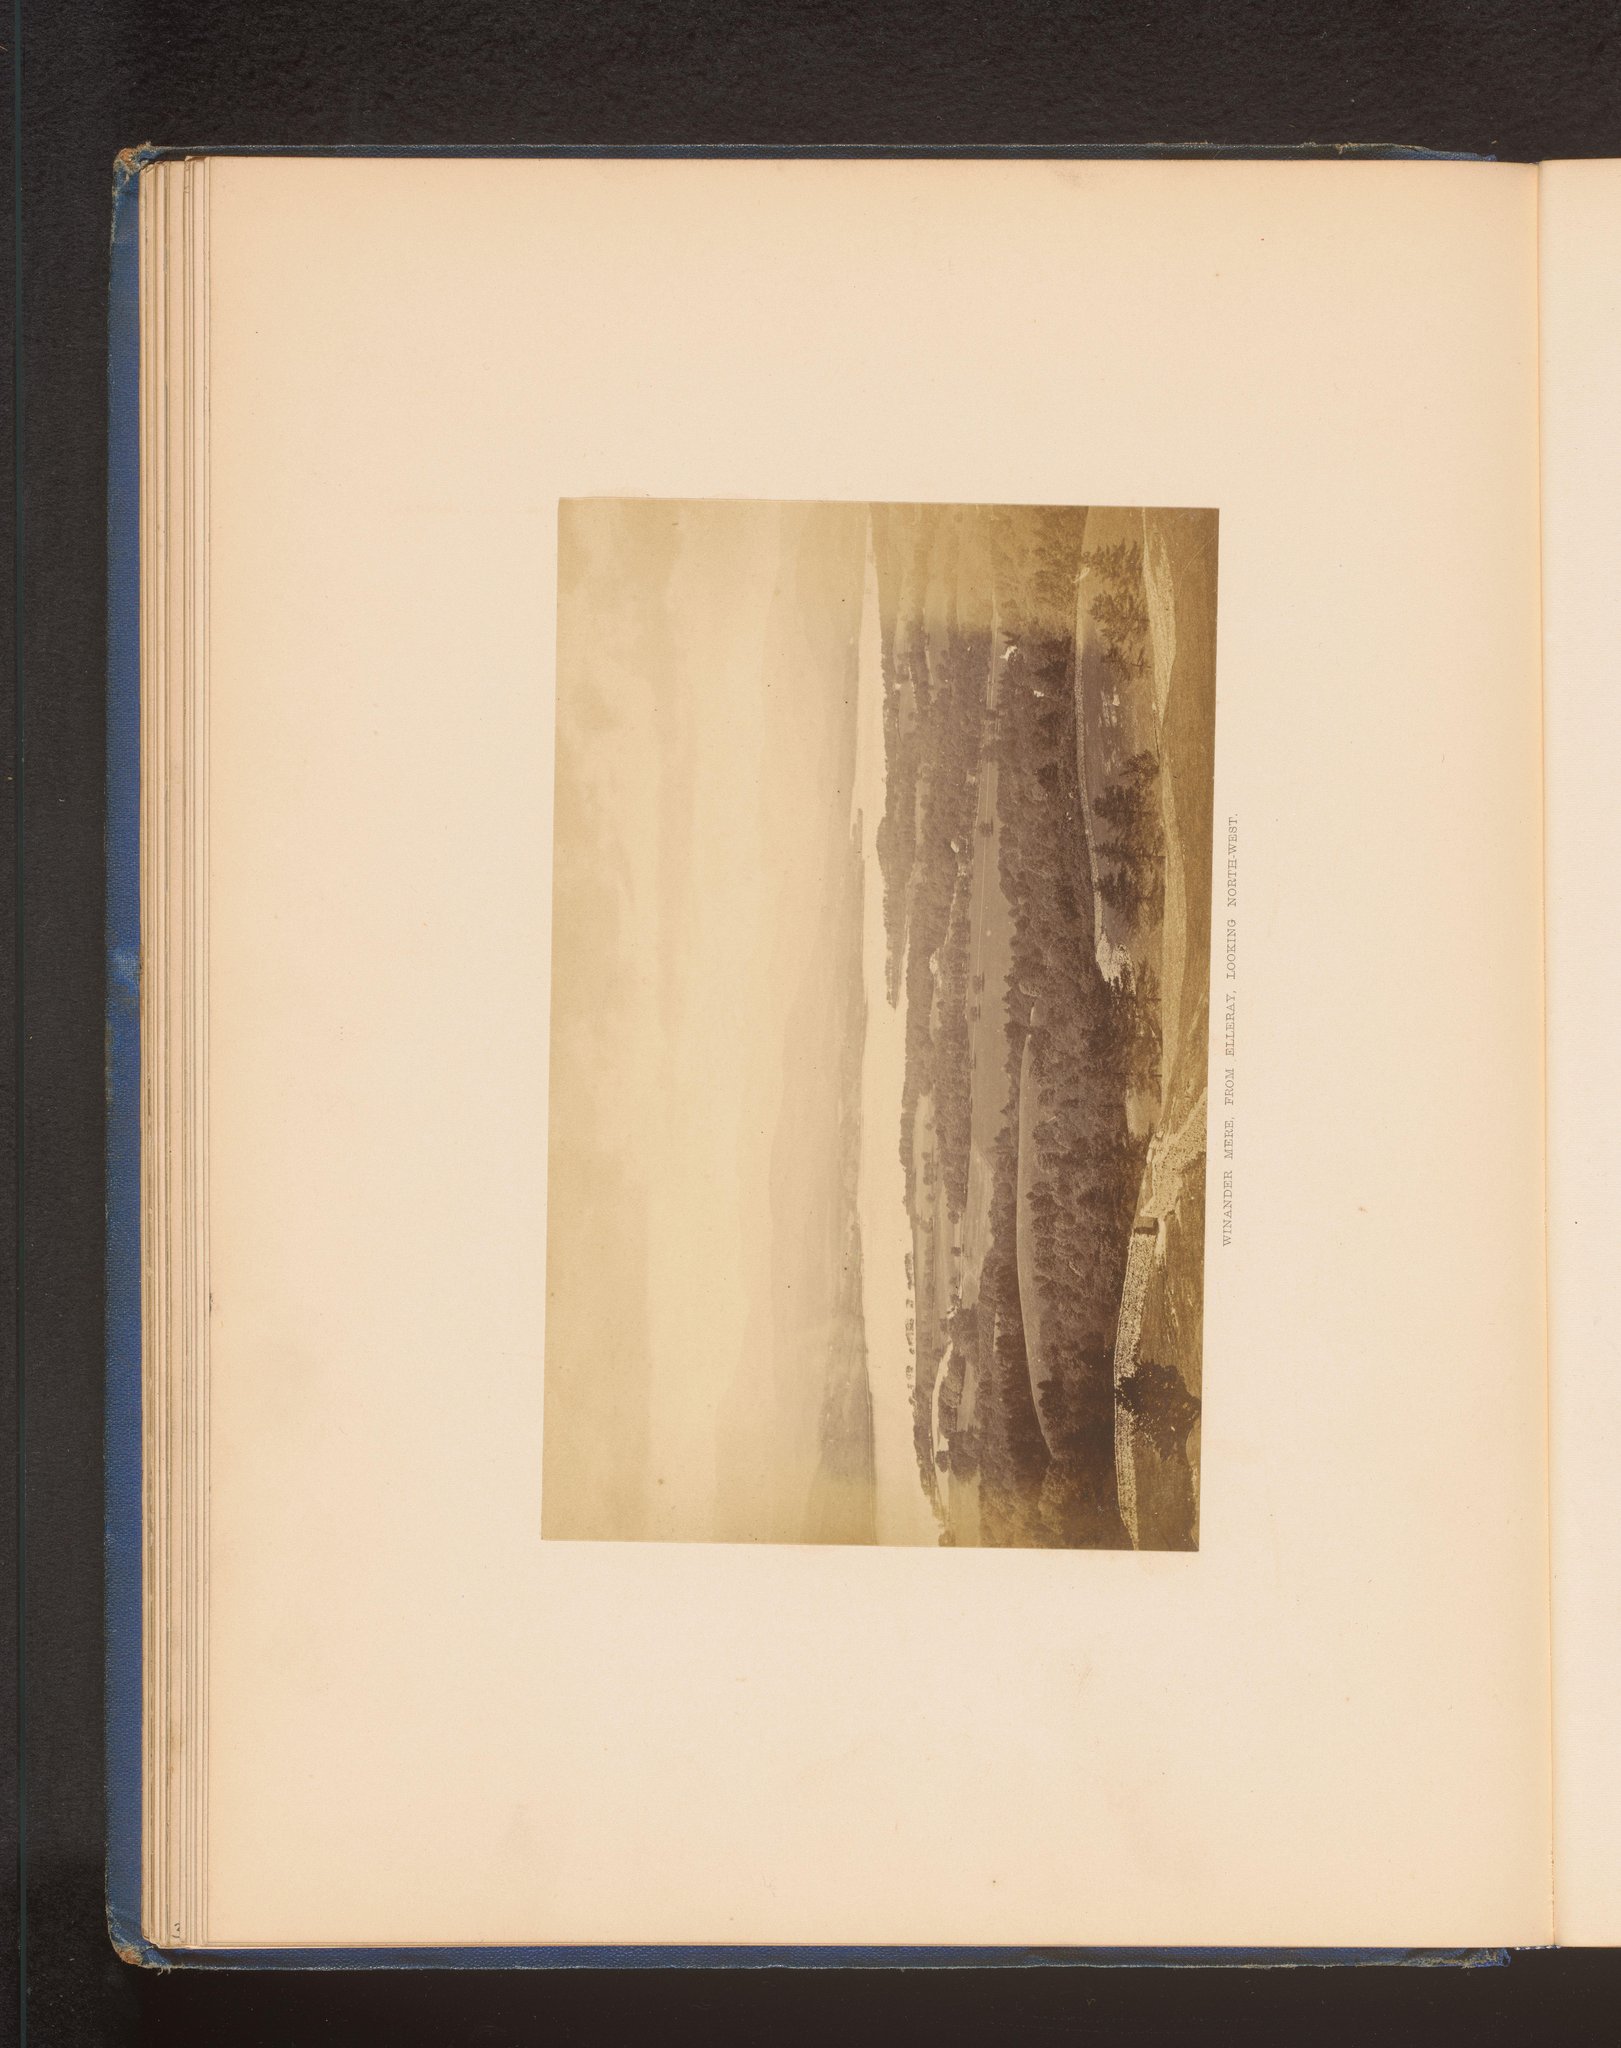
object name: page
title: Winander Mere, from Elleray, looking north-west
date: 1857-1867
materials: photographic support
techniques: albumen print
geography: lake district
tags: lake